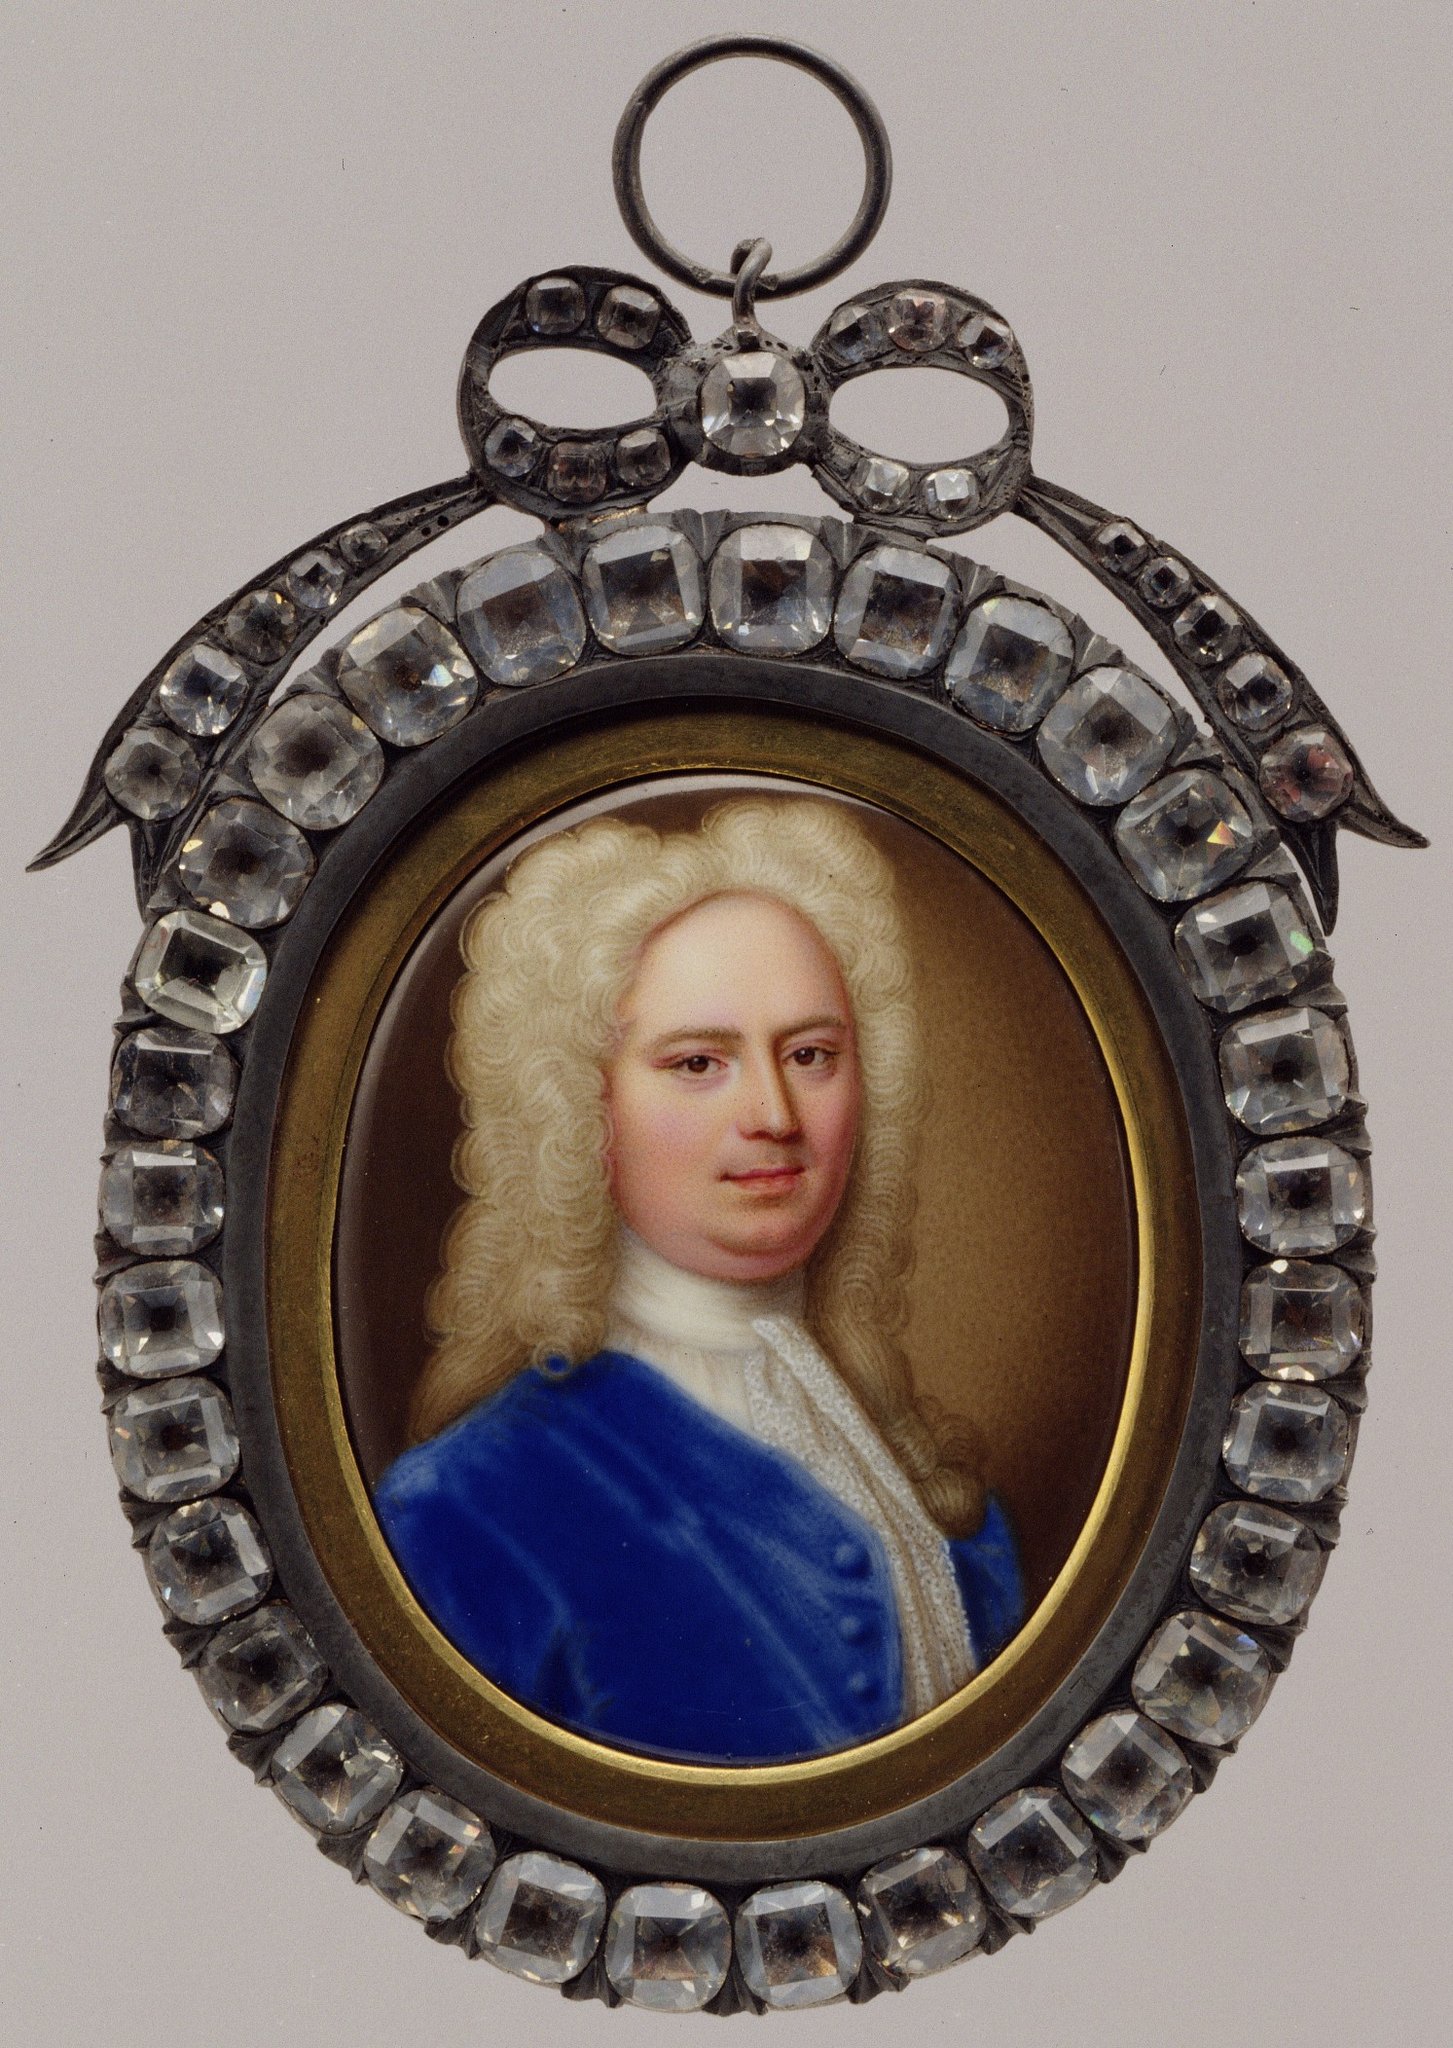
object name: painting, miniature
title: Richard Abell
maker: christian friedrich zincke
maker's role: artist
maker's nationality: german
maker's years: 1683-1767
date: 1724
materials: enamel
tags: men,portraits